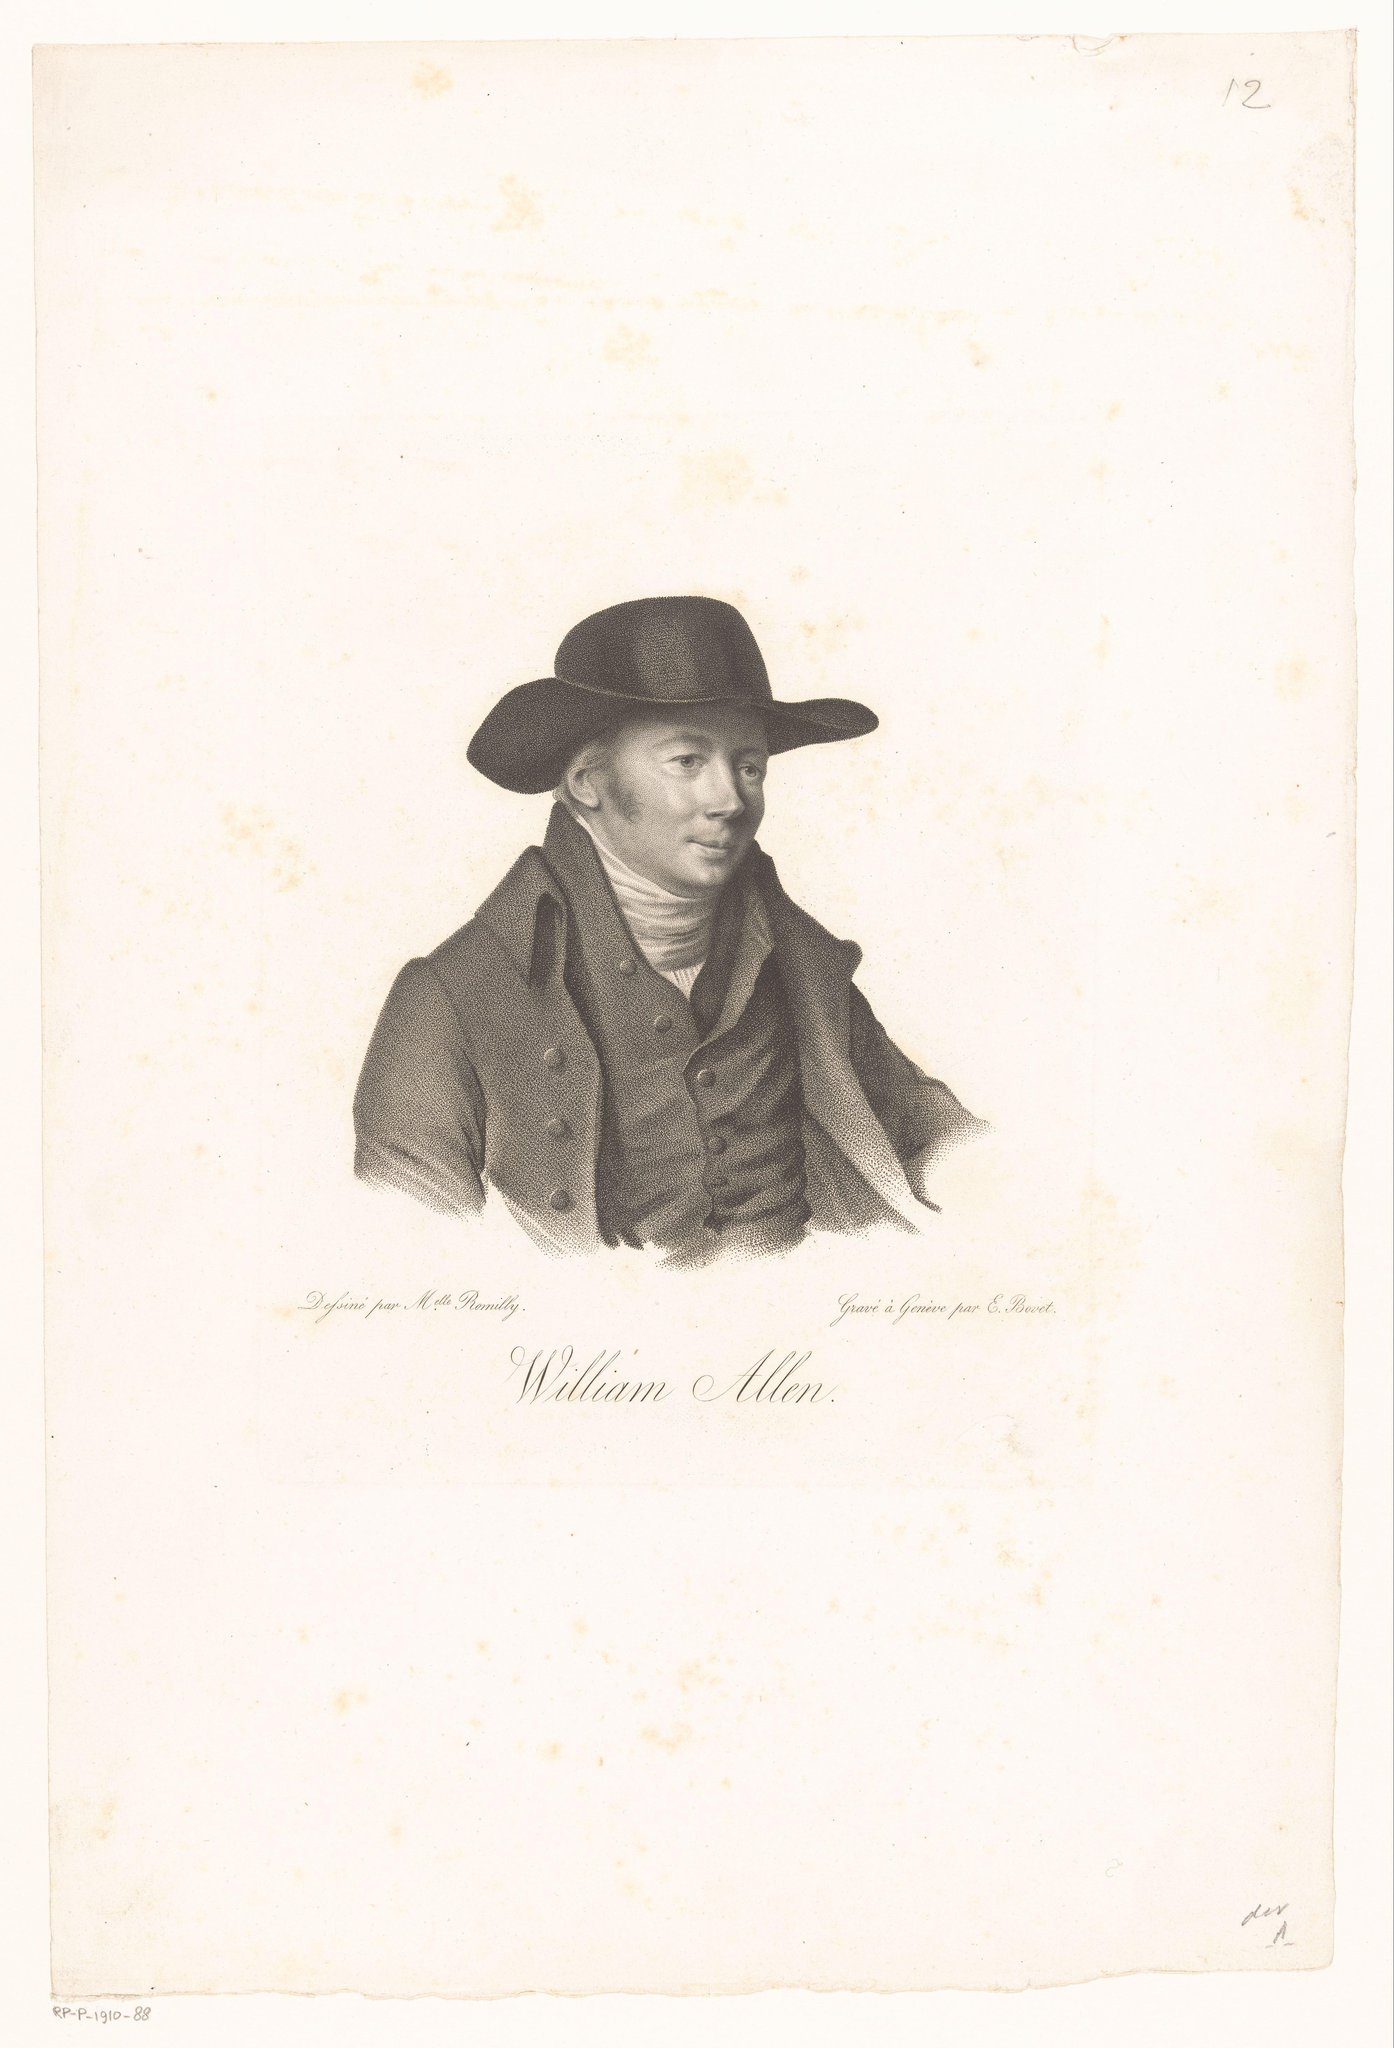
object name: print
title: Portret van William Allen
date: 1811-1875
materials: paper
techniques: engraving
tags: london, historical persons, head-gear: hat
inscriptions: collector's mark: Lugt 2228